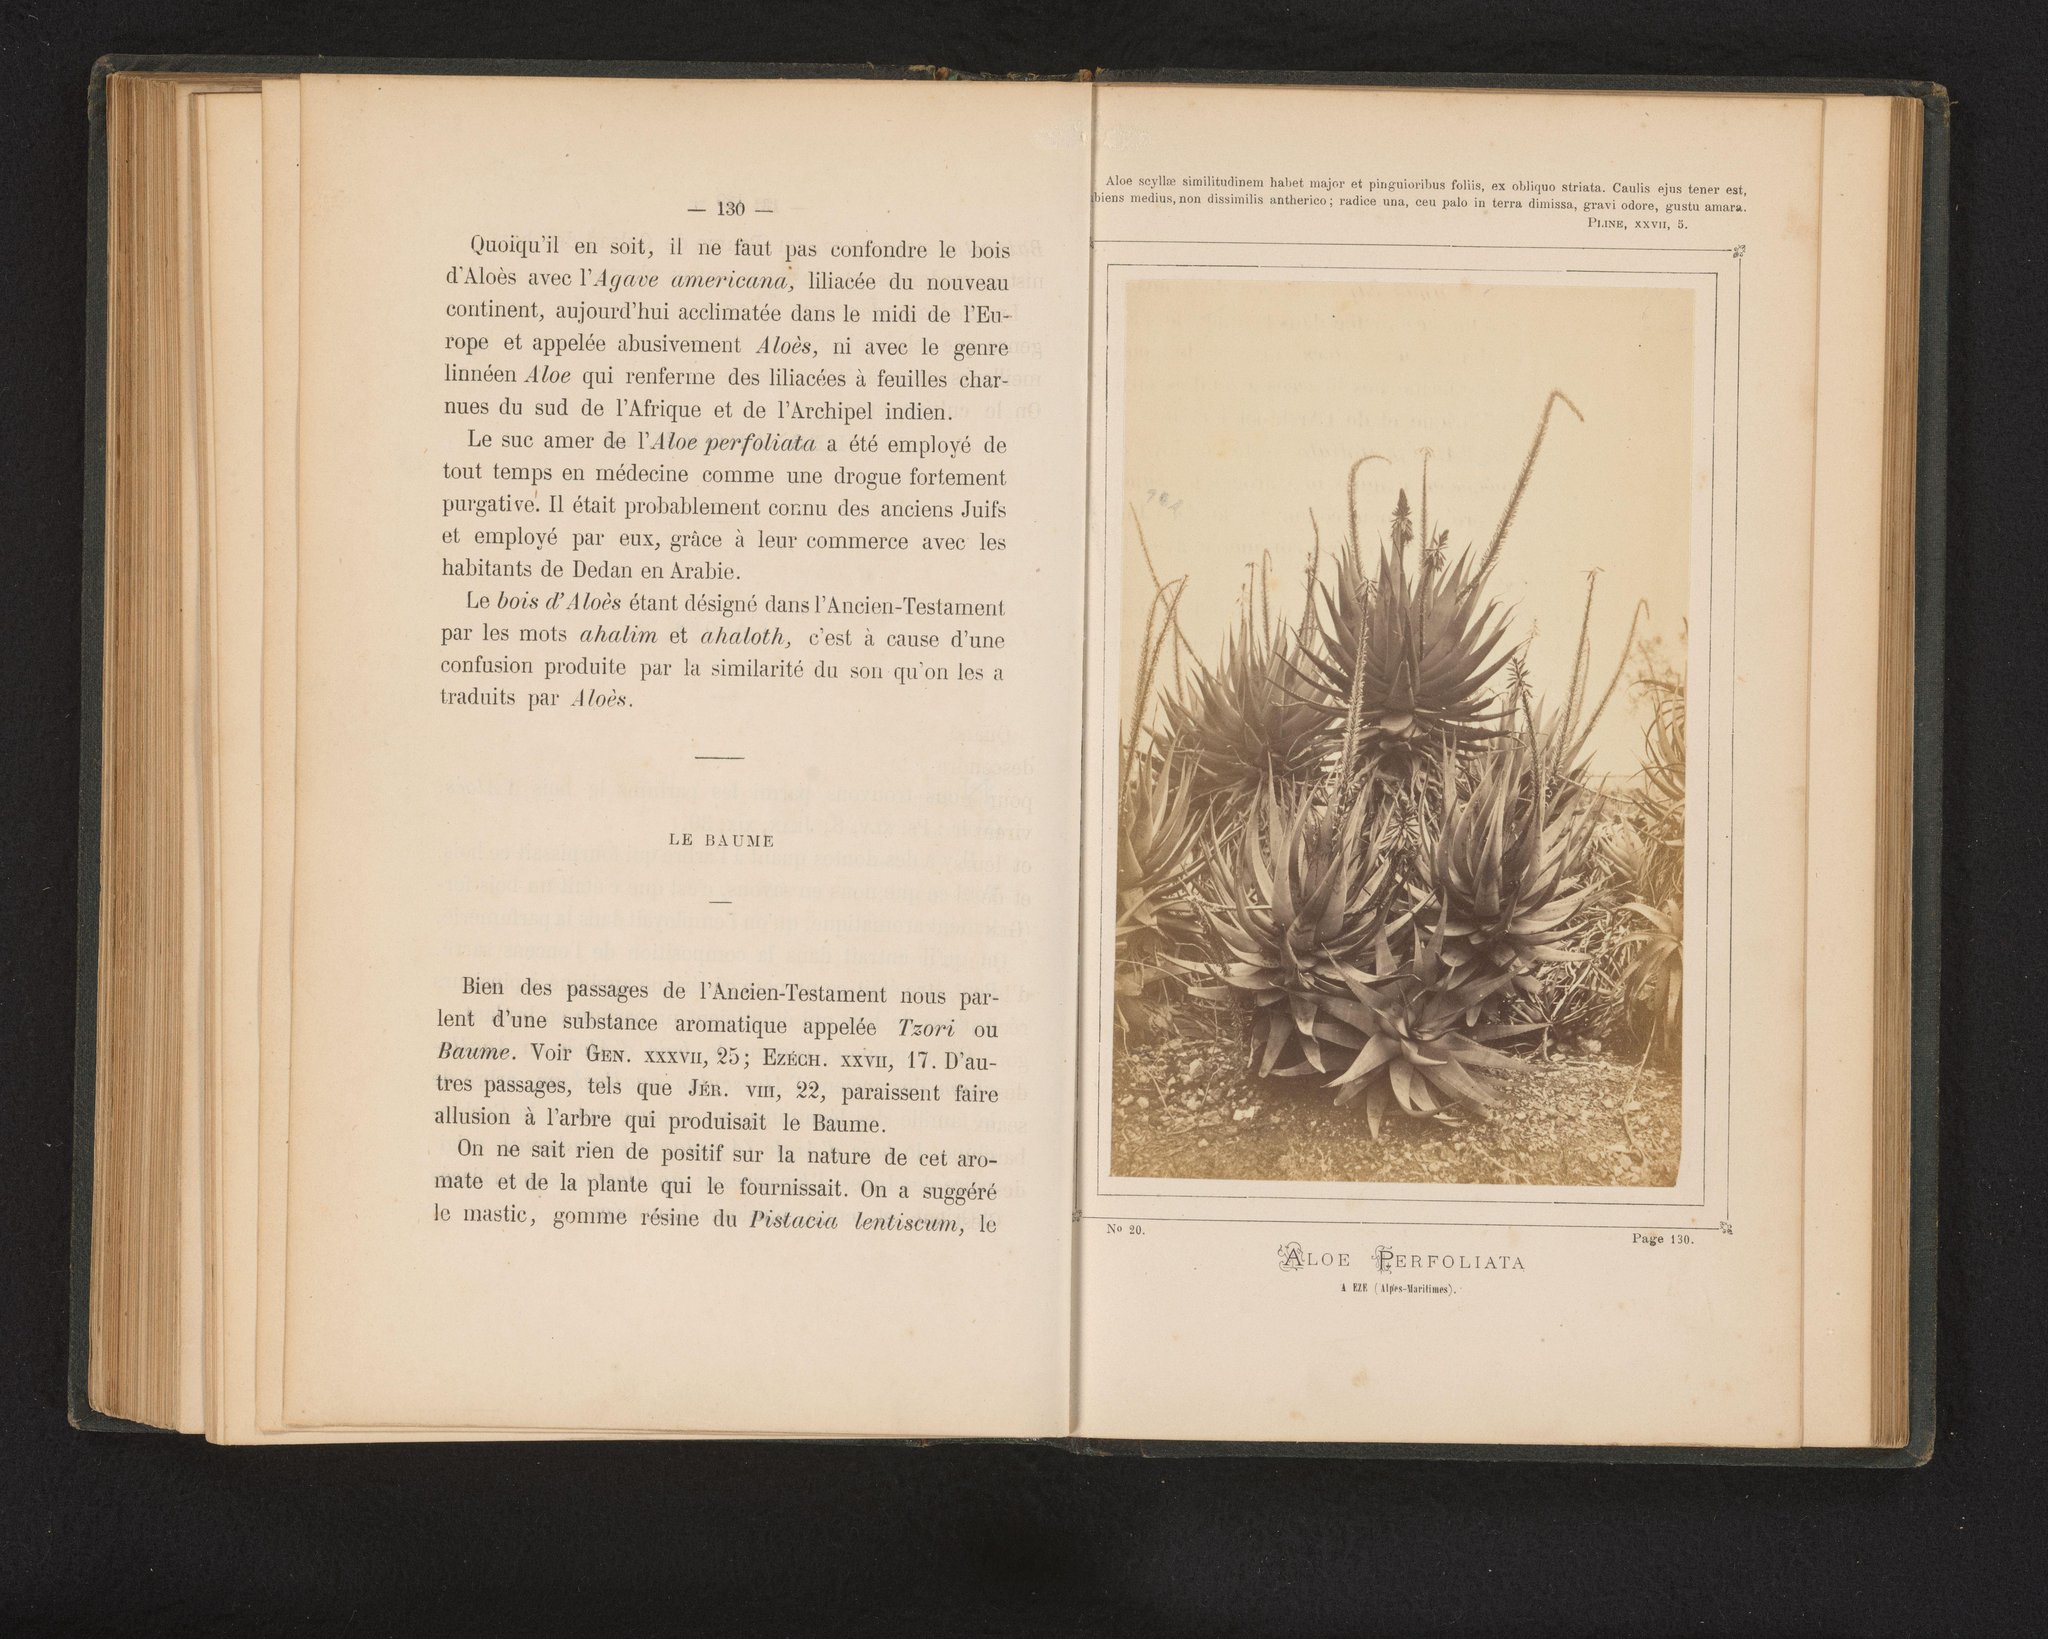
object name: photograph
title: Aloe Perfoliata. A Eze (Alpes-Maritimes)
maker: jean walburg de bray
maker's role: fotograaf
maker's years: 1839-1901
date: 1866-1871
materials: paper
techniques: albumen print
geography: eze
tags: plants and herbs: aloe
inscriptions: inscription: ‘Aloe scyllae similitudinem habet major et pinguioribus foliis, ex obliquo striata. Caulis ejus tener est,/ [...]biens medius, non dissimilis antherico; radice una, ceu palo in terra dimissa, gravi odore, gustu amara./ PLINE, XXVII, 5.’, number: ‘No 20.’, inscription: ‘Page 130.’